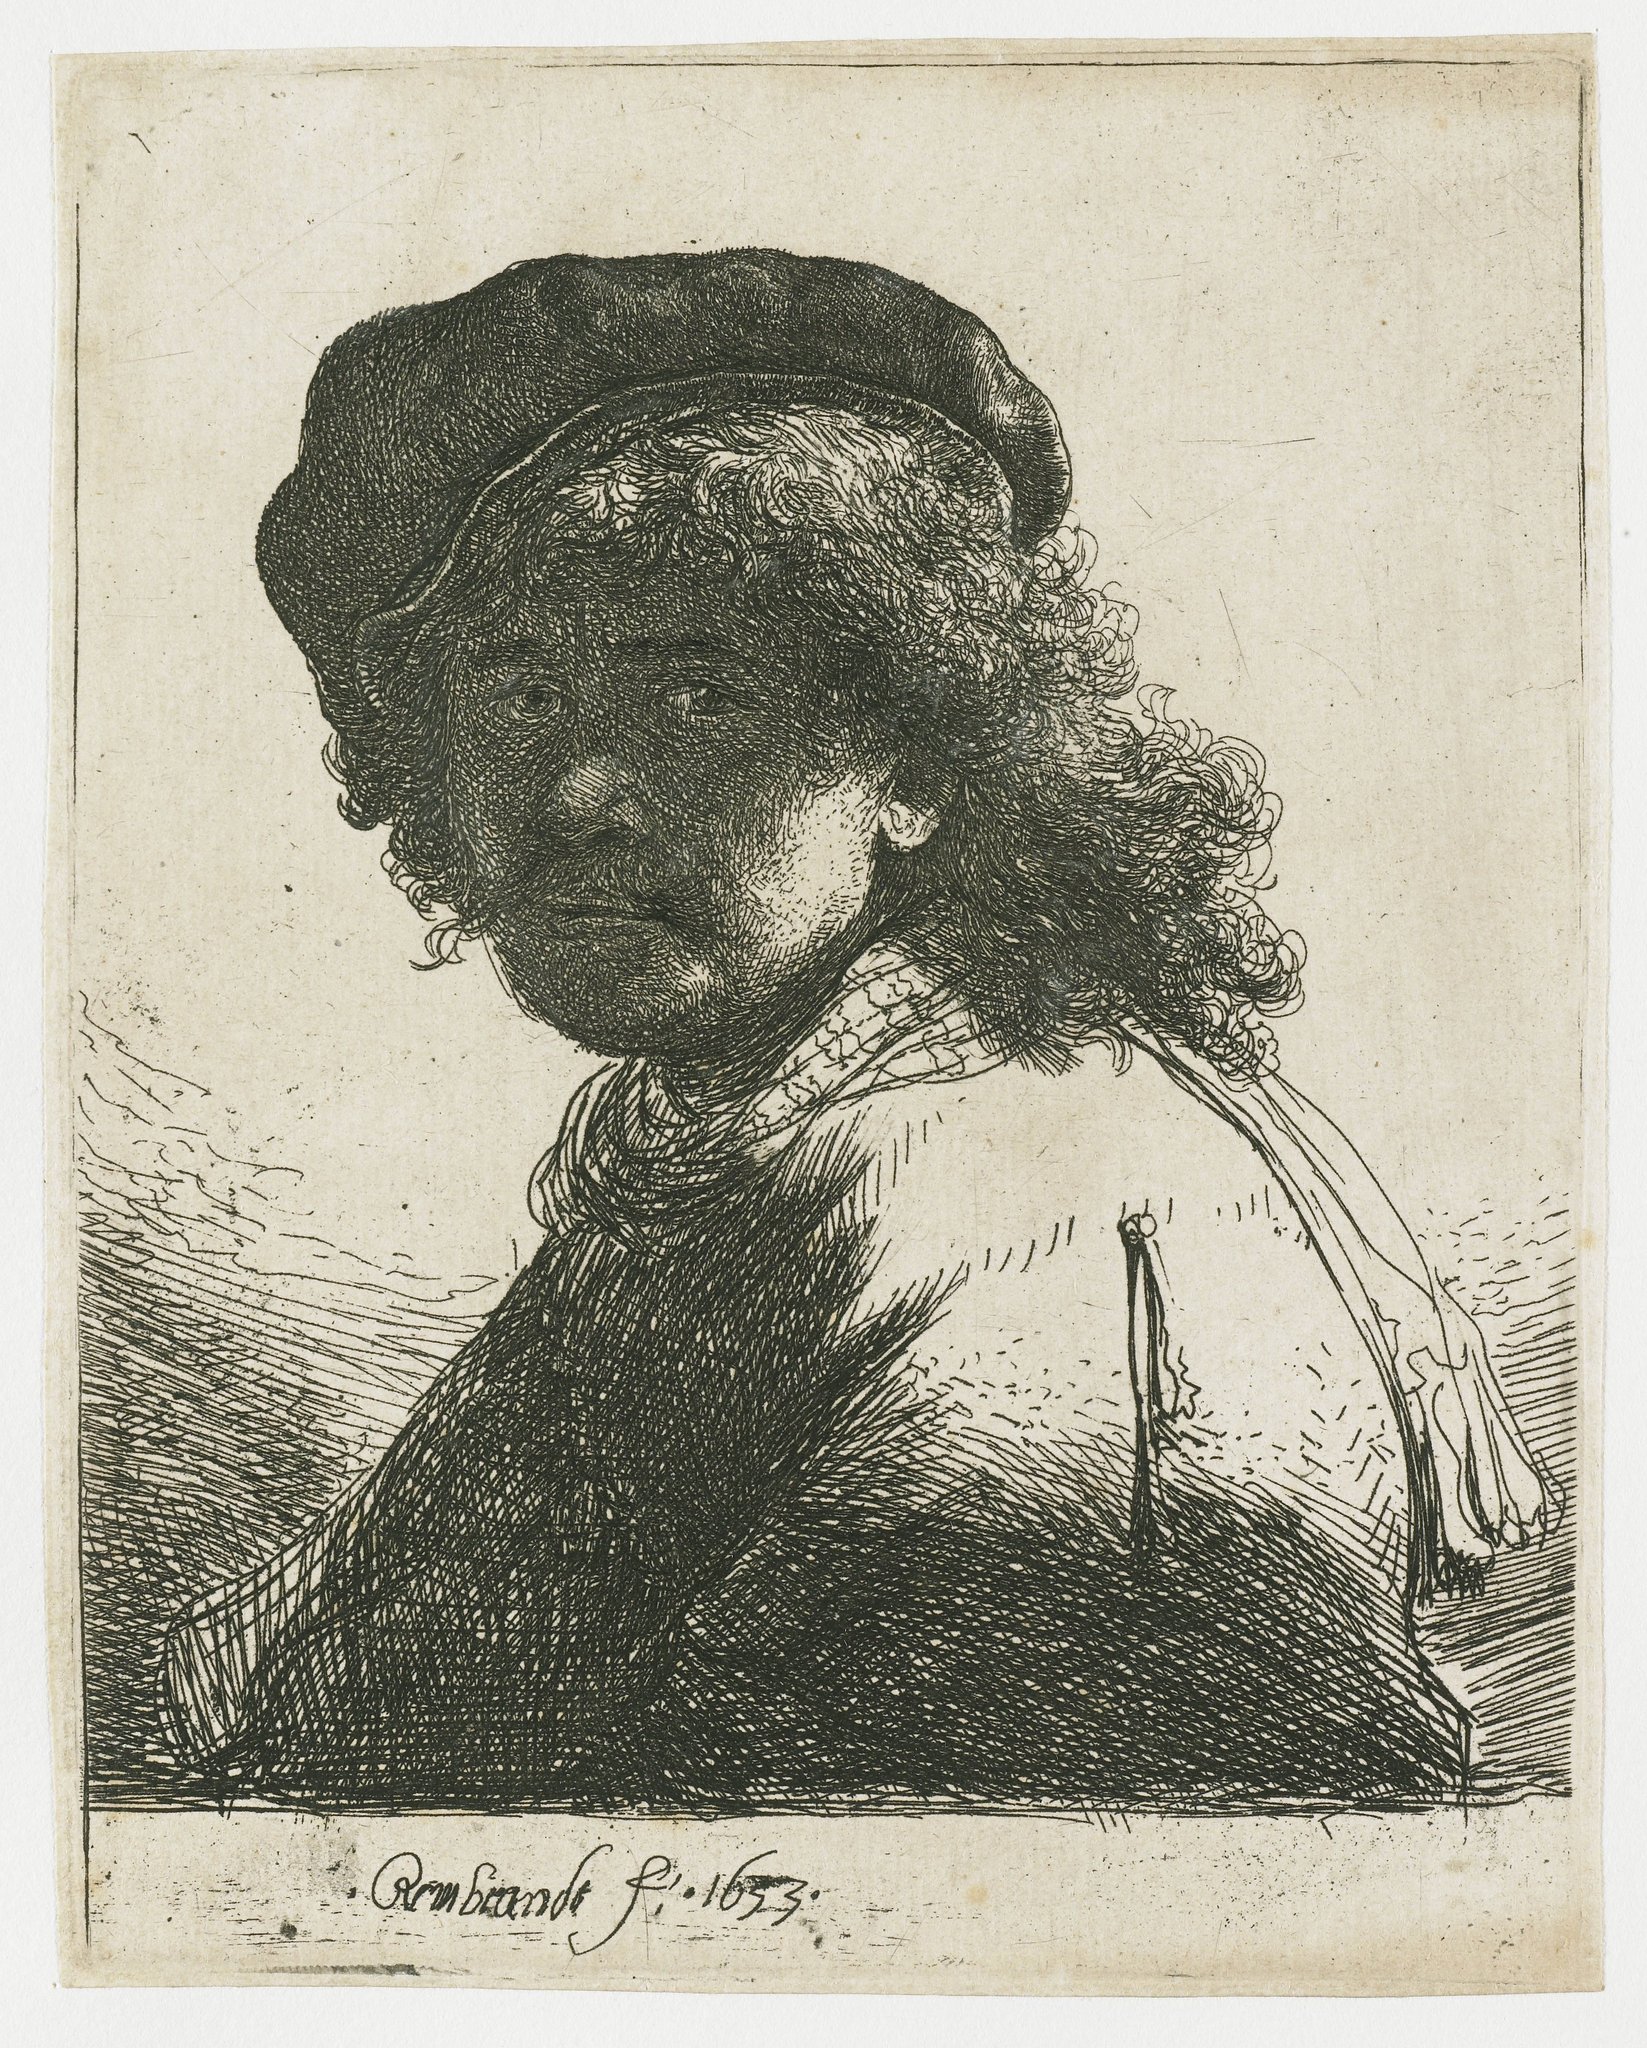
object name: print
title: Self-portrait in a cap and scarf with the face dark: bust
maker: rembrandt van rijn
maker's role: draughtsman, painter, print maker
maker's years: 1606-1669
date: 1633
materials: paper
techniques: etching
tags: leiden, amsterdam, painter, print maker, draughtsman, rembrandt van rijn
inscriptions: signature and date: ‘Rembrandt f. 1633’, inscription: ‘Duhtel W’, collector's mark: Lugt 2165